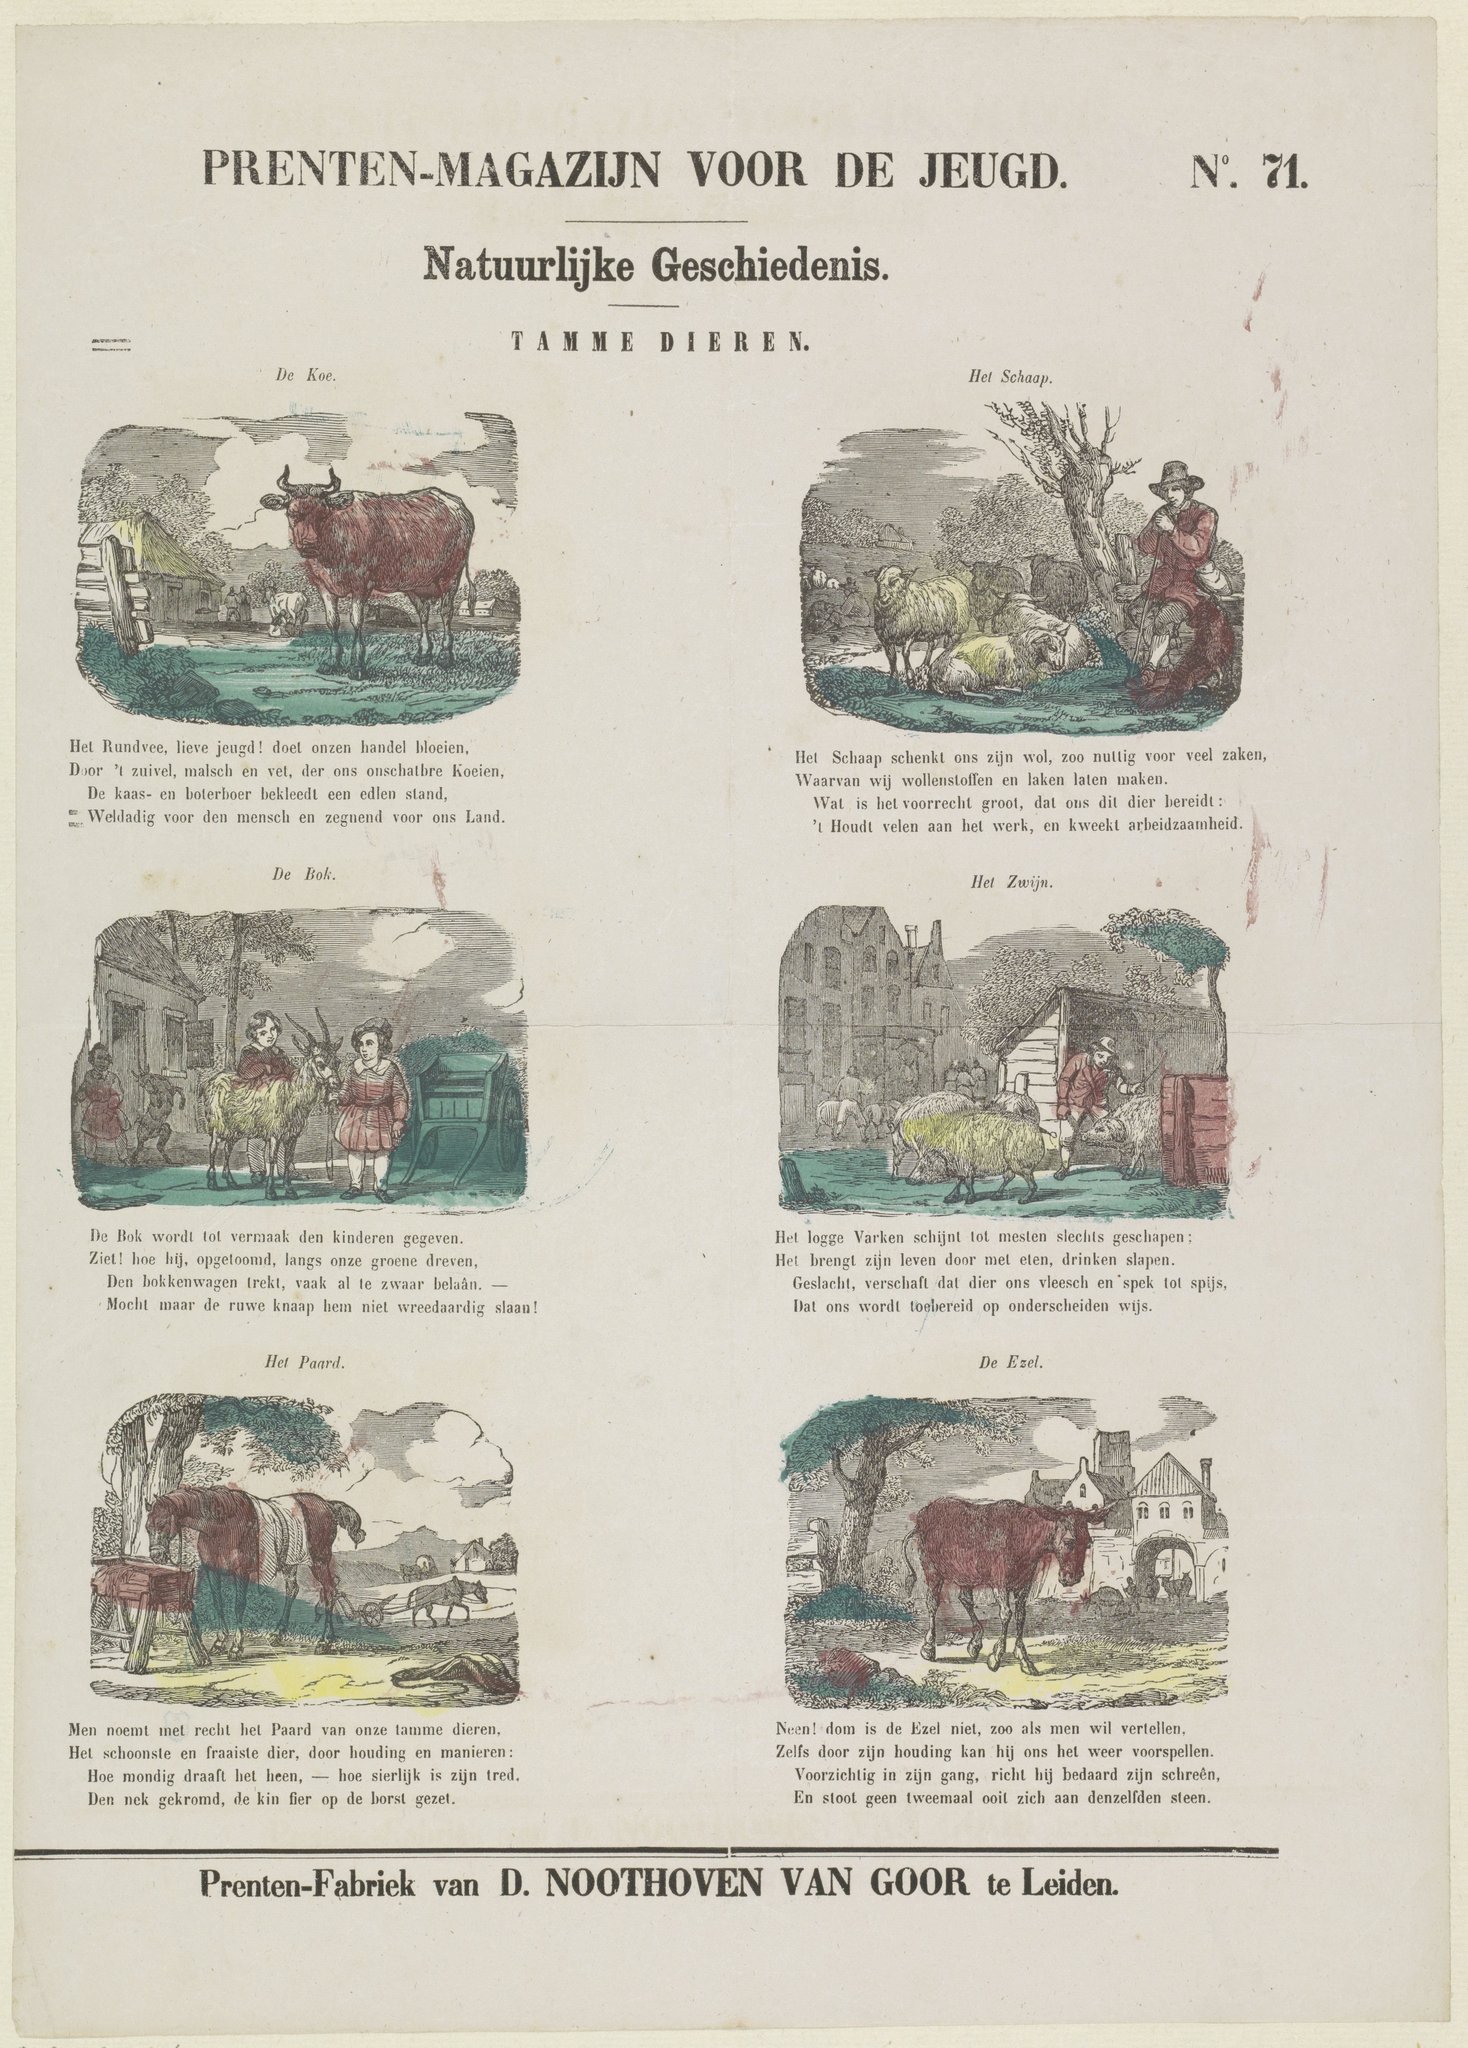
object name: print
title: Natuurlijke geschiedenis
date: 1850-1881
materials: paper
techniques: colour, letterpress printing, engraving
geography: netherlands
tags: pig, cow, animals, ass, donkey, he-goat, billy-goat, sheep, horse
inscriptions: collector's mark: Lugt 2760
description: Blad met 6 voorstellingen van verschillende dieren: een koe, een schaap, een bok, een zwijn, een paard en een ezel. Boven elke voorstelling een titel en onder elke voorstelling een vierregelig vers. Genummerd rechtsboven: No. 71.